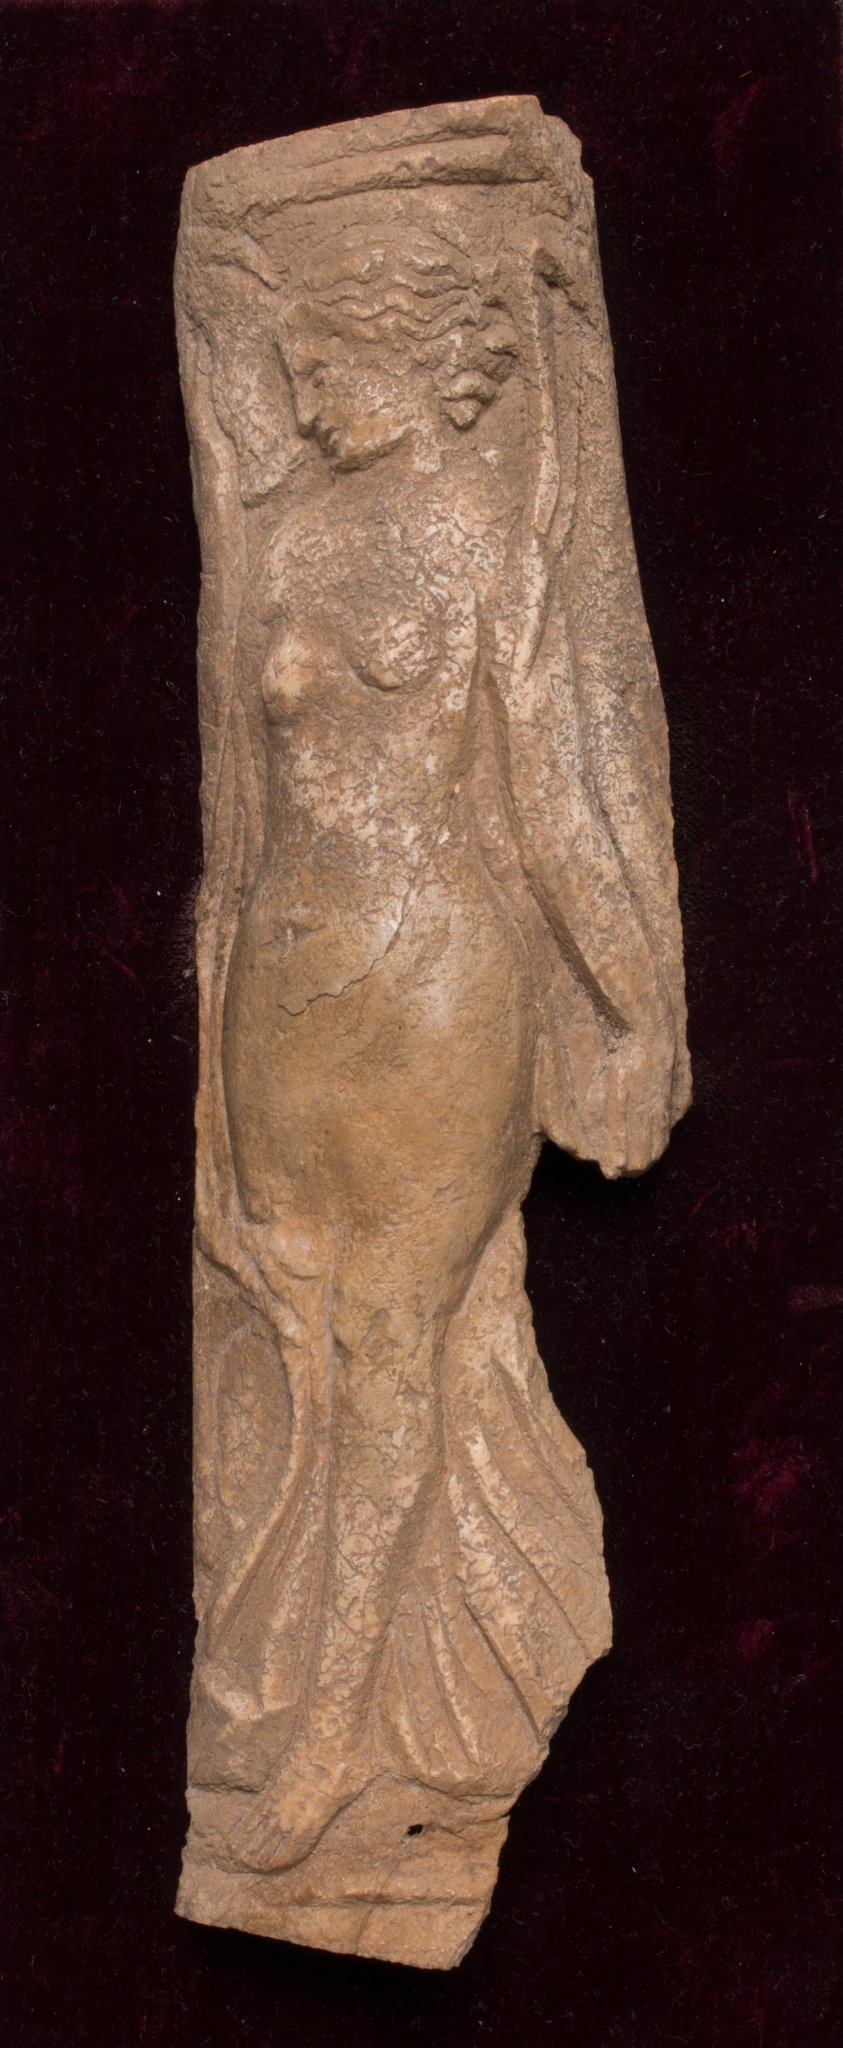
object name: plaque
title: Bone plaque with Female Dancer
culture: byzantine or roman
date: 301-600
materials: bone